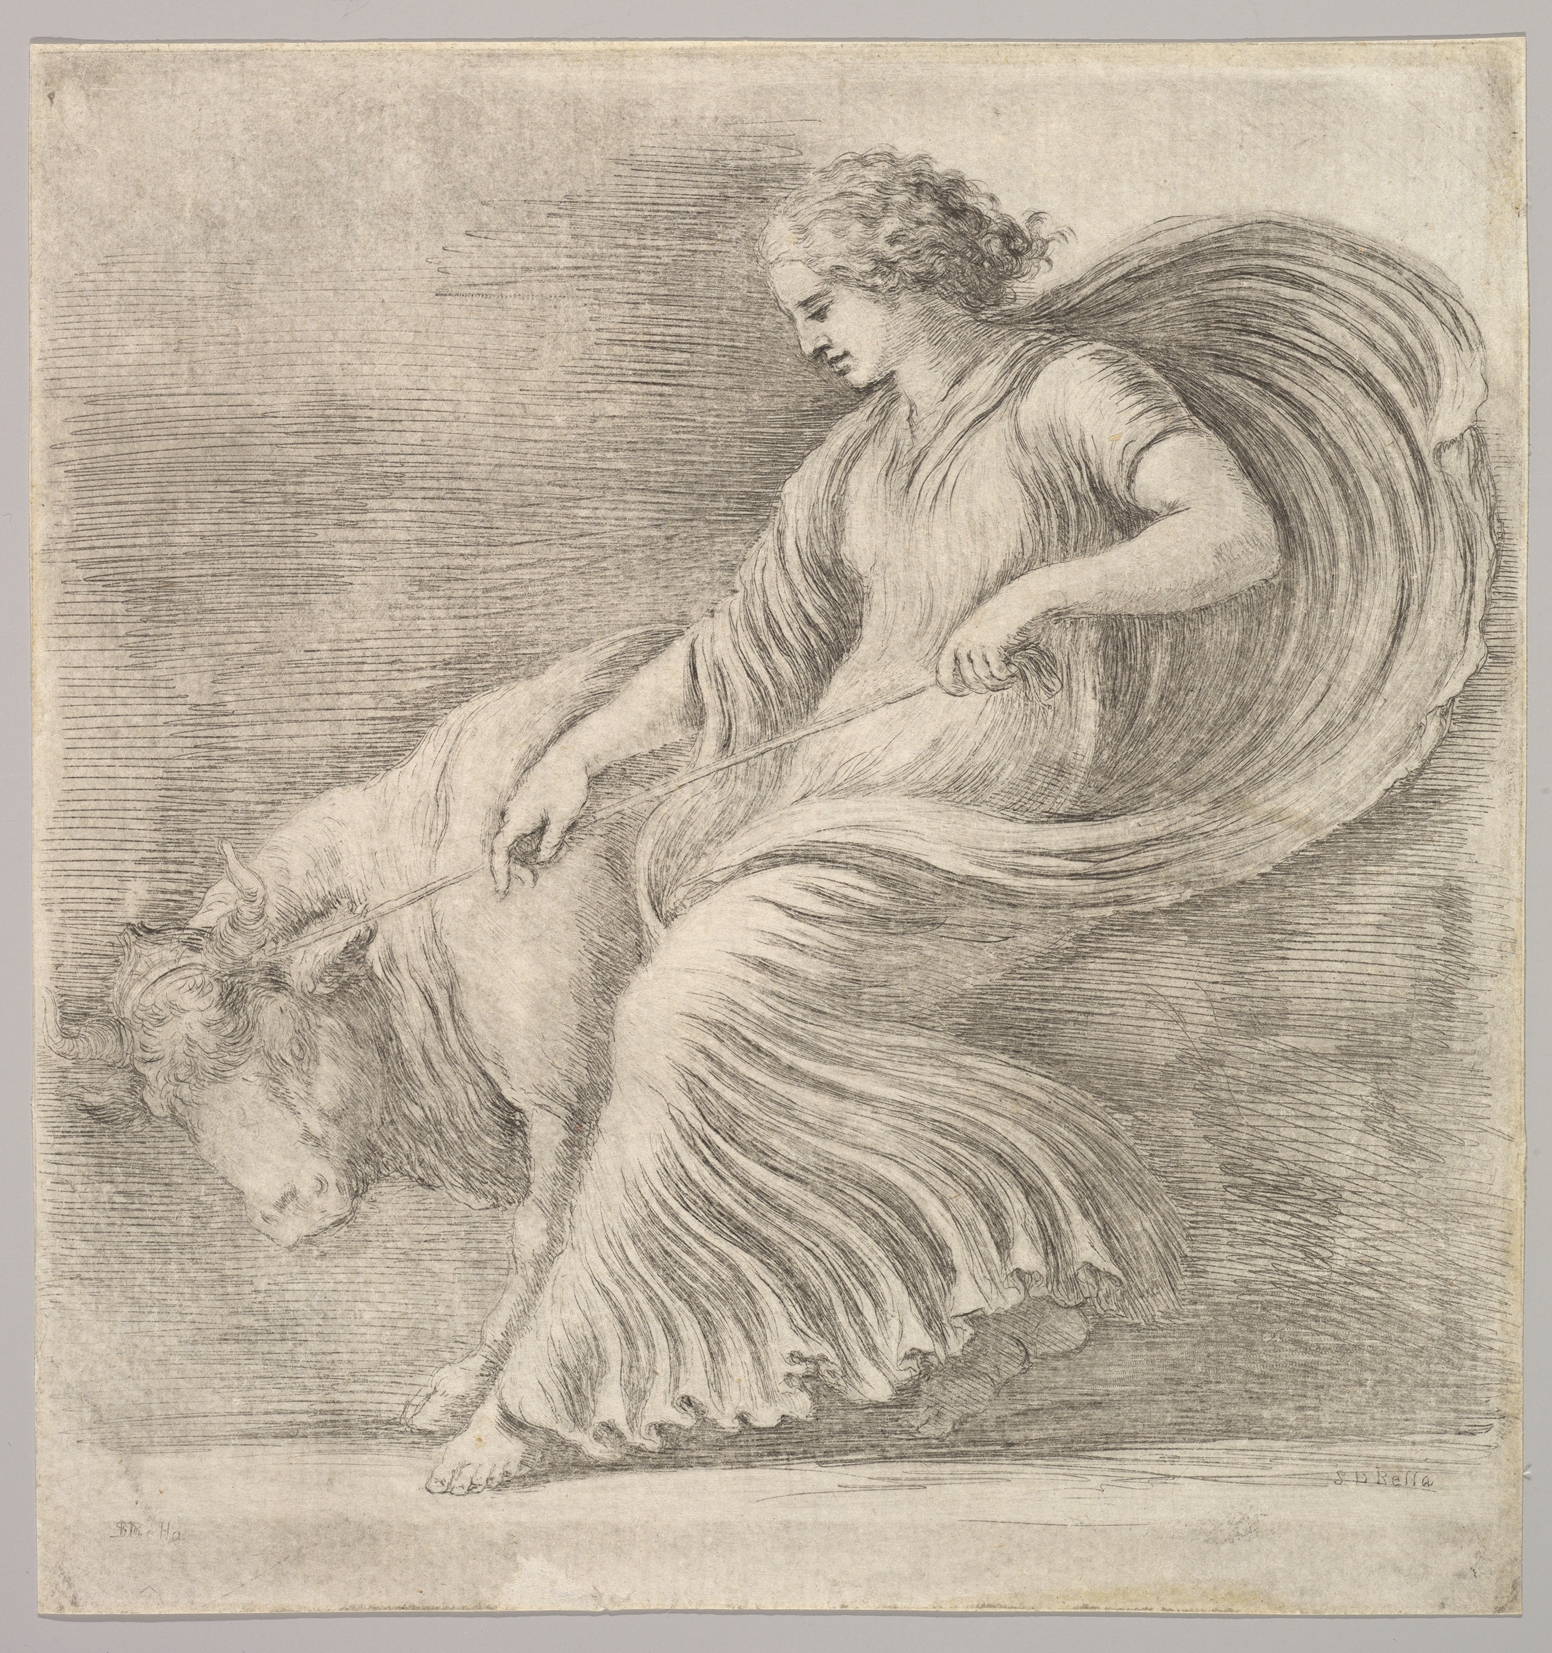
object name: print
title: A woman in profile pulling back on a rope tied around the horns of a young bull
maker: stefano della bella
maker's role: artist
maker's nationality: italian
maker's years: 1610-1664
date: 1660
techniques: etching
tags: profiles,women,bulls